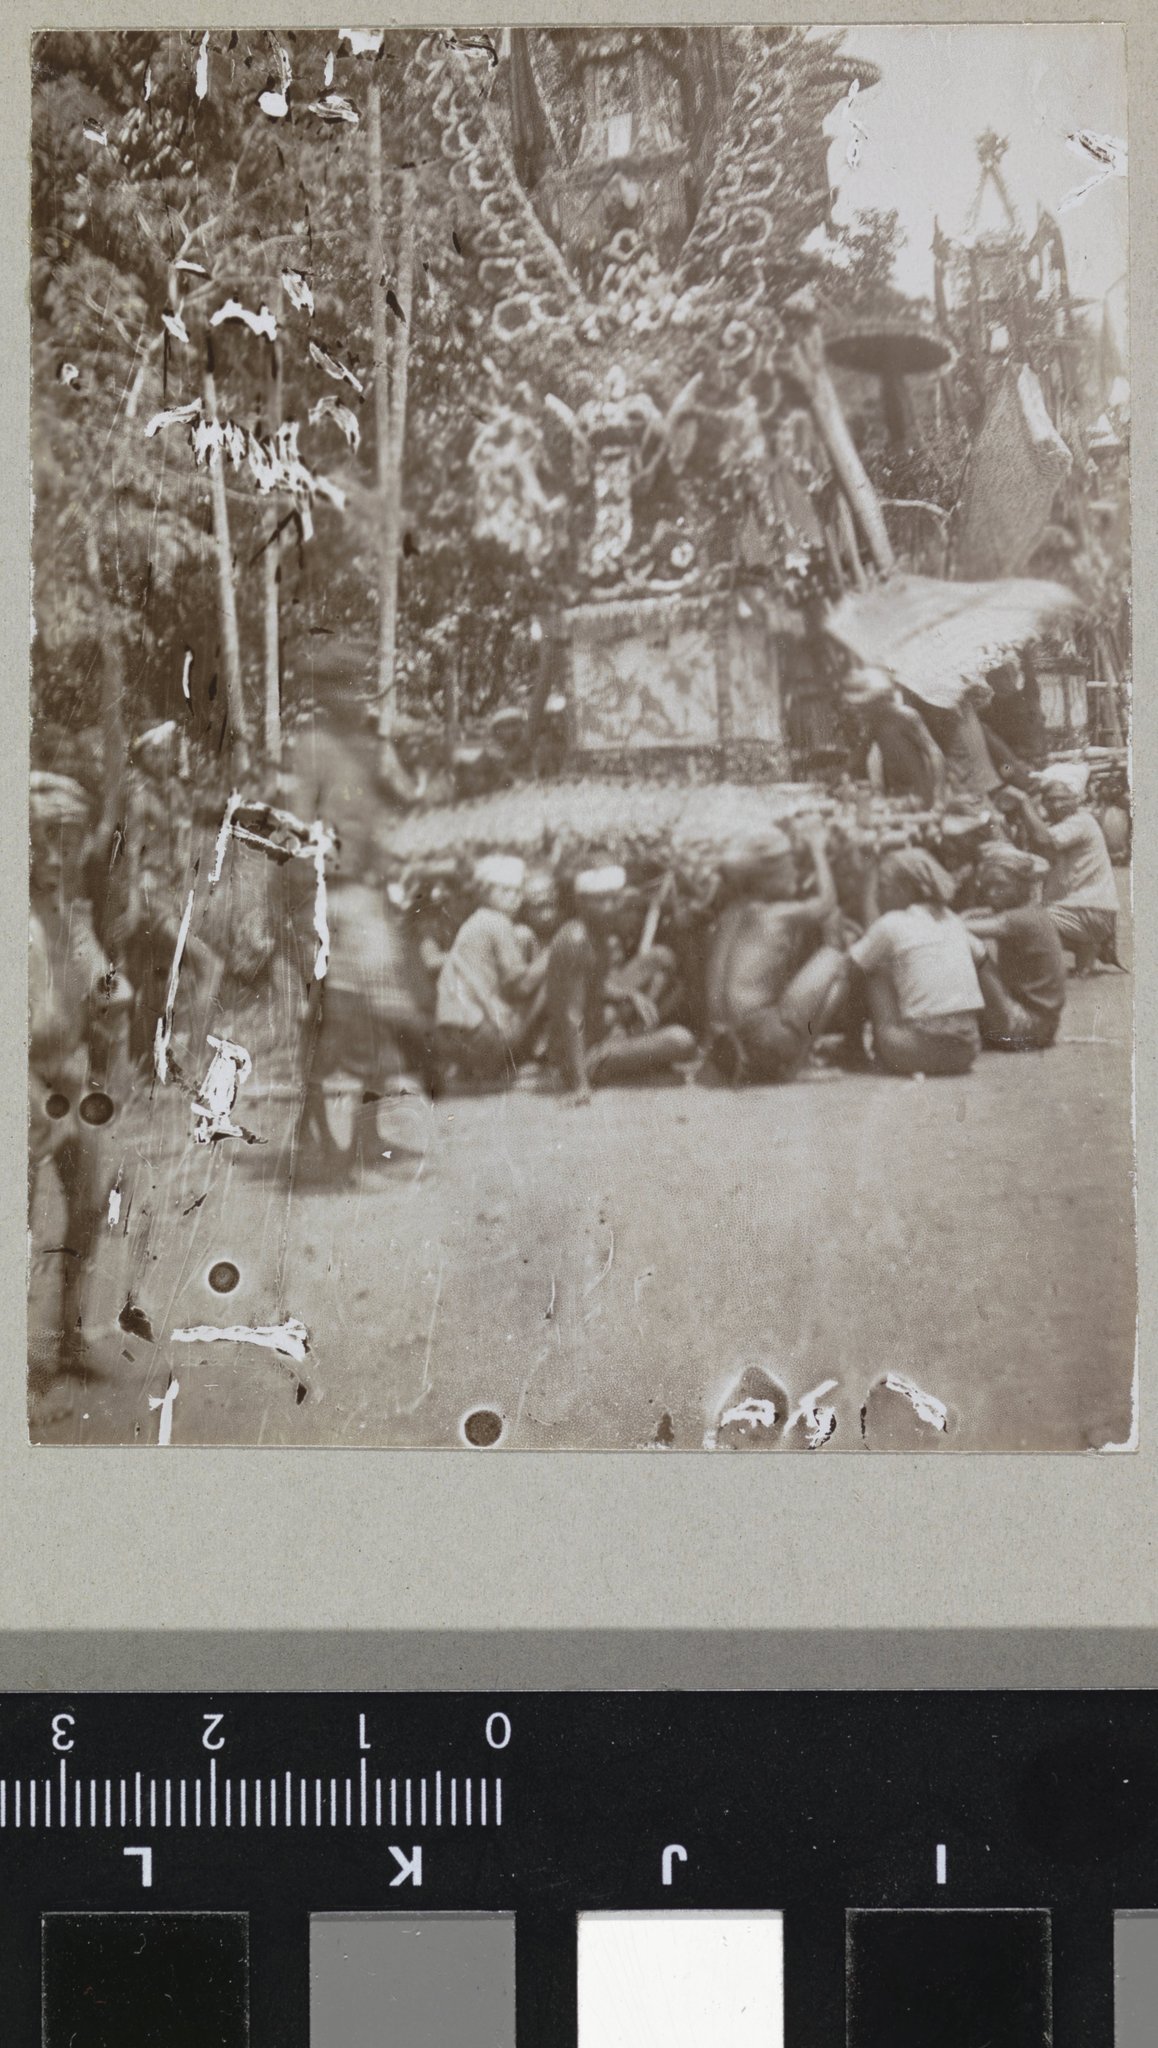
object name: photograph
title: Lijkbaar omringd door mensen, Bali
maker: Anonymous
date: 1910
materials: cardboard, paper, photographic support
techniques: collodion silver print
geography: bali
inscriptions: annotation: ‘Lijkverbrandingsfeesten te Bali 1910.’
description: Foto genomen tijdens lijkverbrandingsfeesten op Bali in 1910.